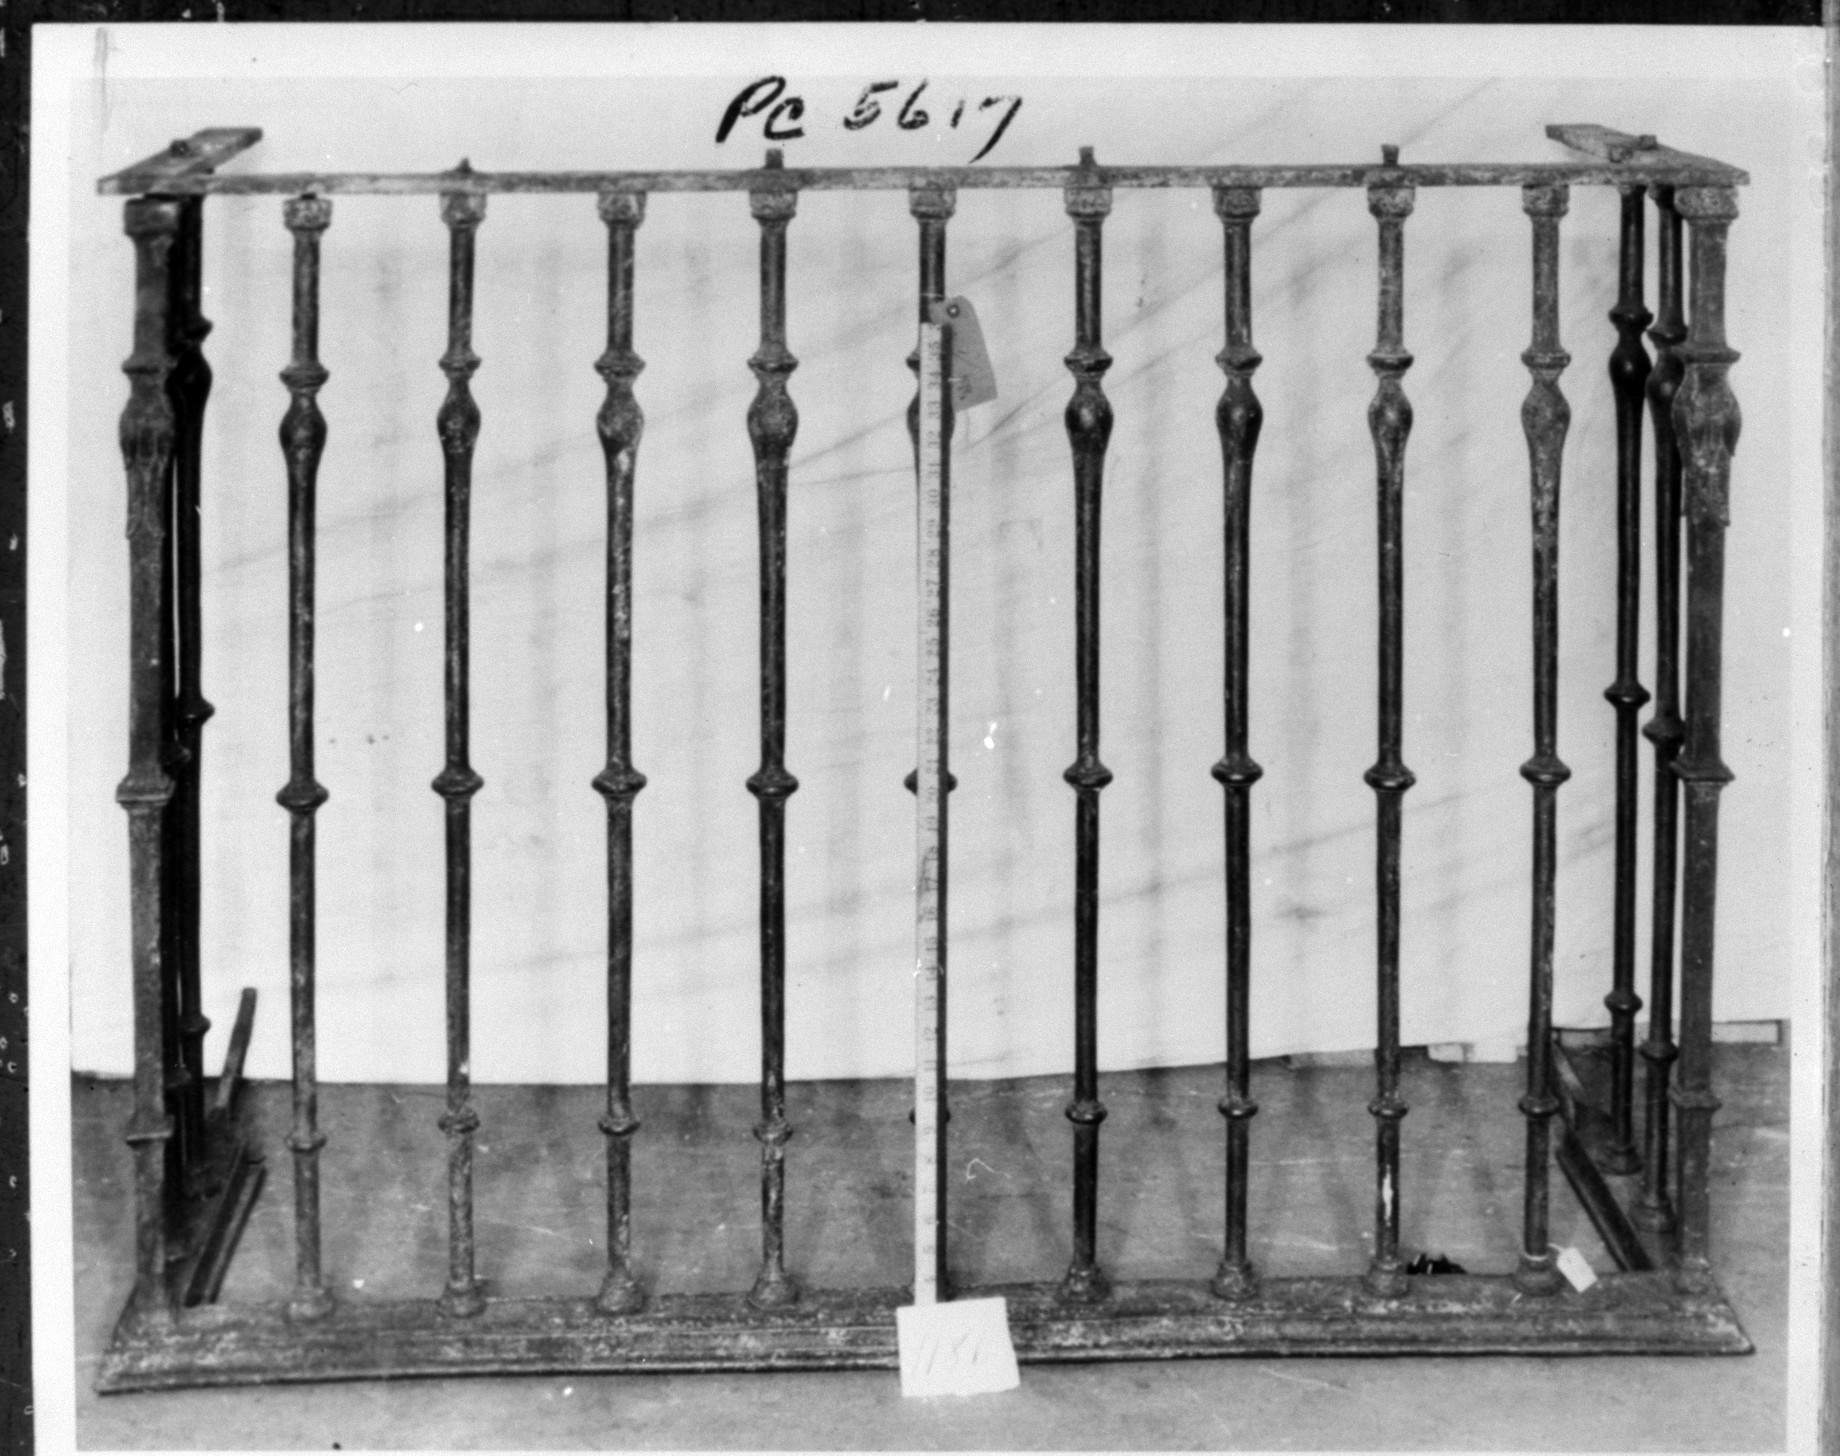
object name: balcony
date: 1601-1700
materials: iron